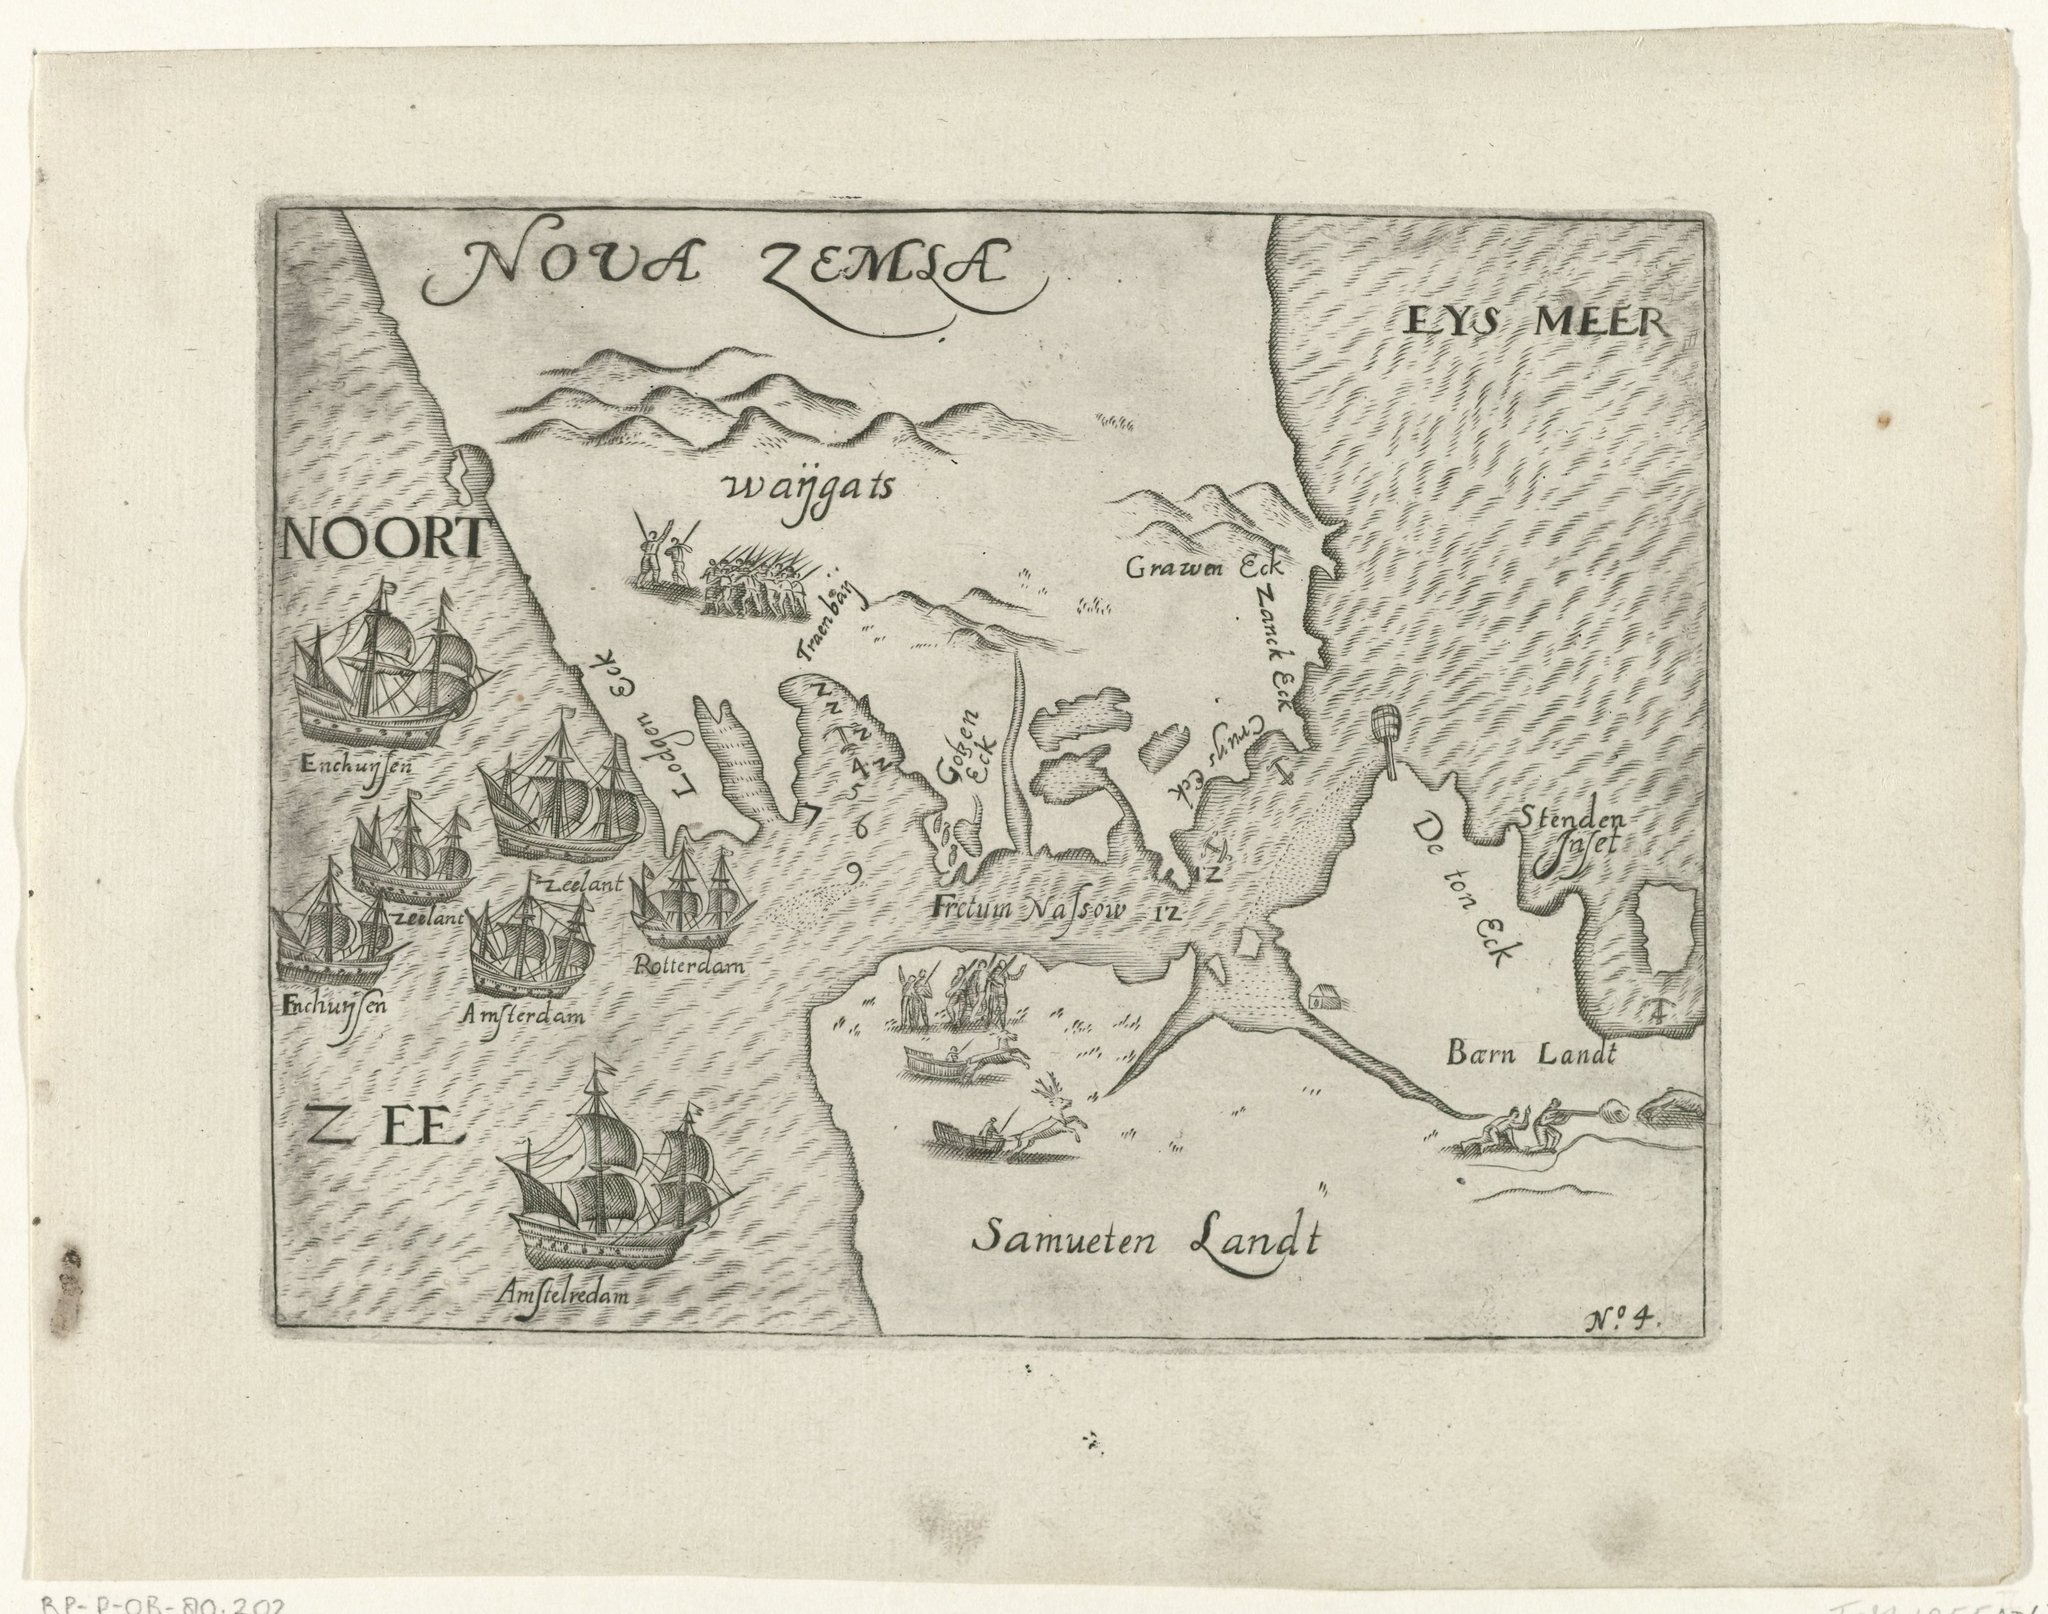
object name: print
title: Aankomst van de zeven schepen bij de straat Waygats, 1595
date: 1615-1617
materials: paper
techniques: engraving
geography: northern netherlands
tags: willem barendsz., jacob van heemskerck, landscapes in polar regions, exploration, expedition, voyage of discovery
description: Gebruikt als illustratie eerst in: G. de Veer, De waerachtige beschrijvinge vande drie seylagien, drie jaren achter mal-kanderen deur de Hollandtsche ende Zeelandtsche Schepen, by noorden Noorweghen, Moscovien ende tartarien nae de Coninckrijcken van Catthay ende China ghedaene, [Michiel Colijn, Amsterdam 1617]. Later gebruikt in: Kort verhael van d'eerste Schipvaerd der Hollandsche ende Zeeusche Schepen by noorden Noorwegen, Moscovien ende Tartarien om, nae de Coningrijcken van Cathay ende China, getogen uyt het Journael van Gerrit de Veer. Opgenomen in: I. Commelin, Begin ende voortgangh, van de Vereenighde Nederlantsche Geoctroyeerde Oost-Indische Compagnie, J. Janssonius, Amsterdam 1646. Genummerd: No. 4.